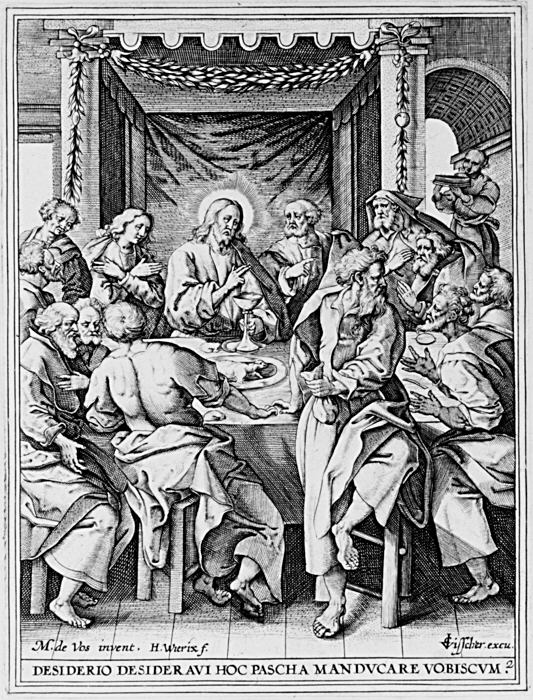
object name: print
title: The Last Supper (Desiderio Desideravi), from "The Passion of Christ (Passio Domni Nostri Jesu Christi)"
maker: hieronymus wierix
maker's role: artist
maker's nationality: netherlandish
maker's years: 1553-1619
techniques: engraving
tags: men,women,jesus,last supper